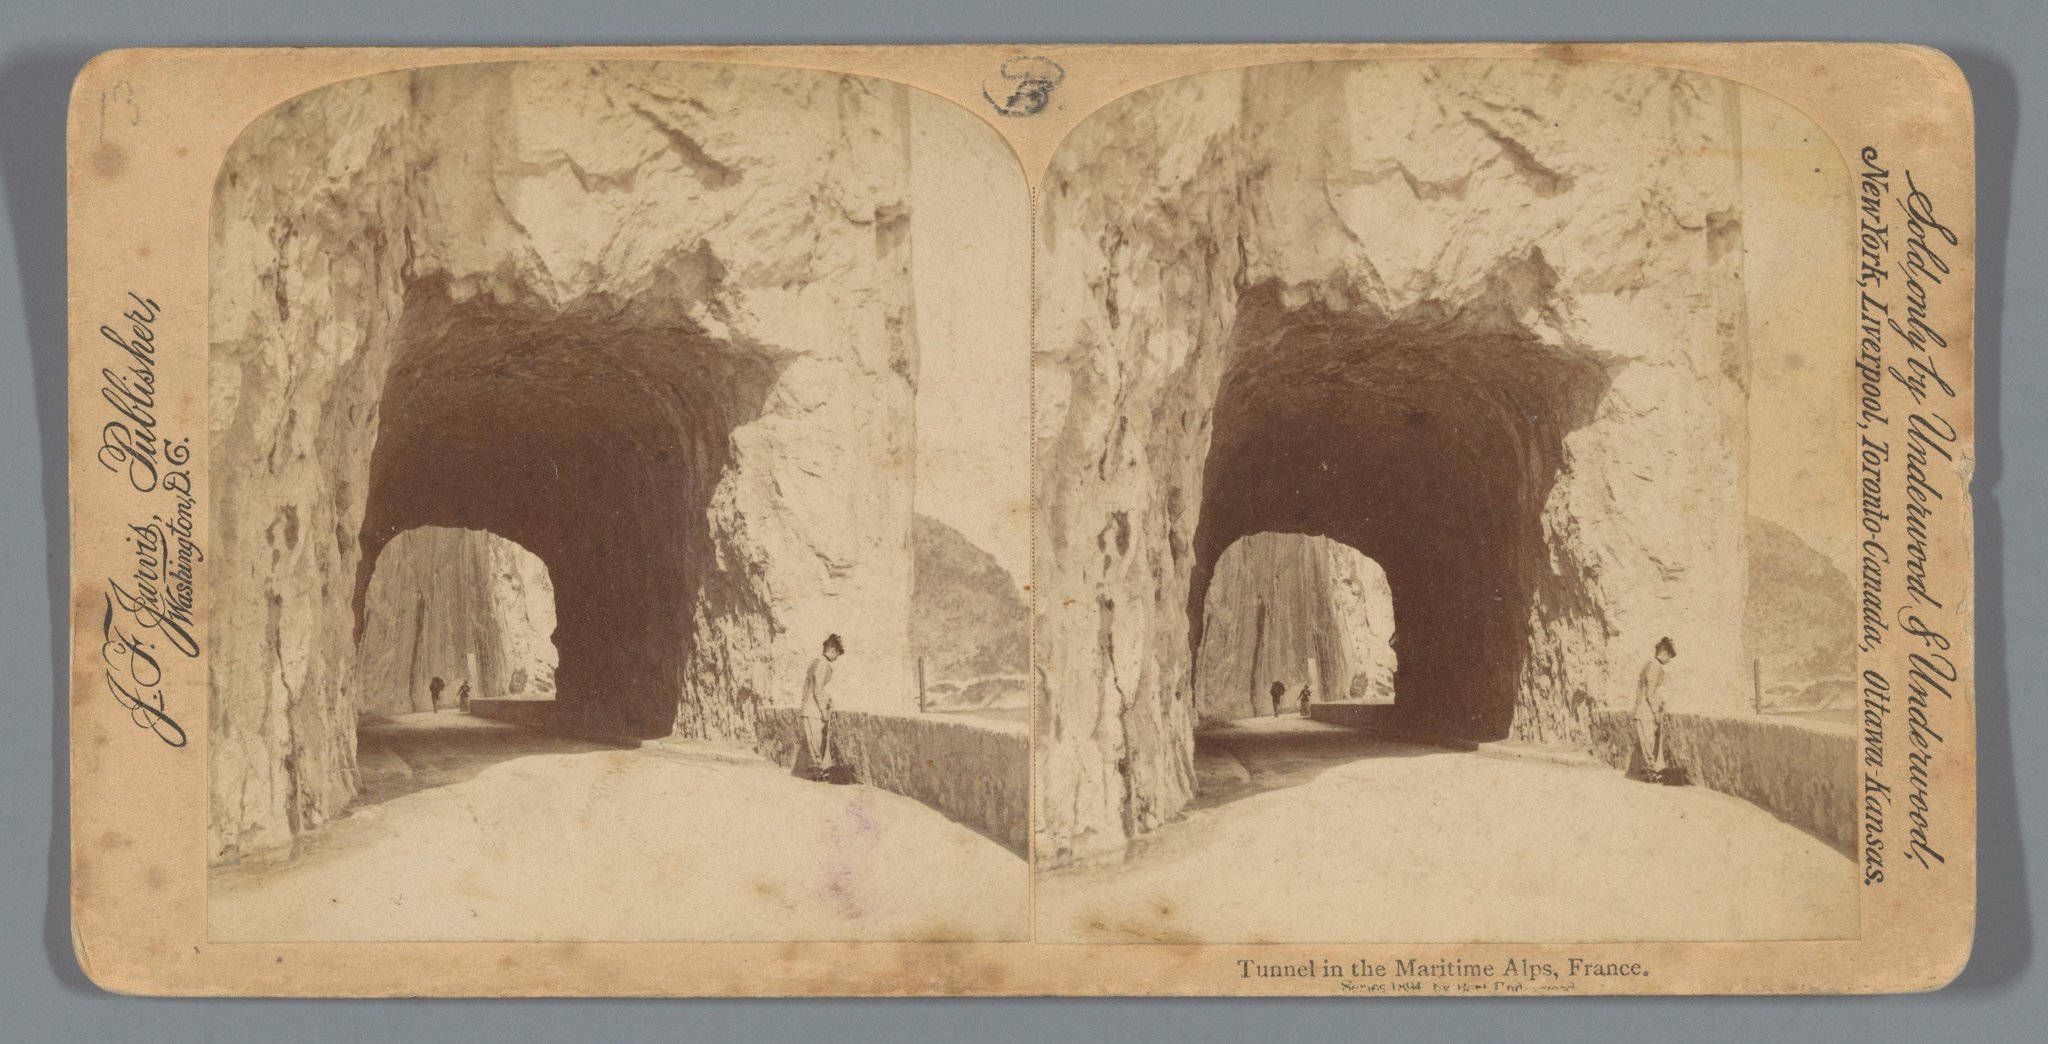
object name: stereograph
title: Tunnel in the Maritime Alps, France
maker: john fillis jarvis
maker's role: publisher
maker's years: 1849-1931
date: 1894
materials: cardboard, photographic support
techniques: albumen print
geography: washington d.c.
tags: underground road, tunnel, mountains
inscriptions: inscription: ‘Sold only by Underwood & Underwood, New York, Liverpool, Toronto-Canada, Ottawa-Kansas’